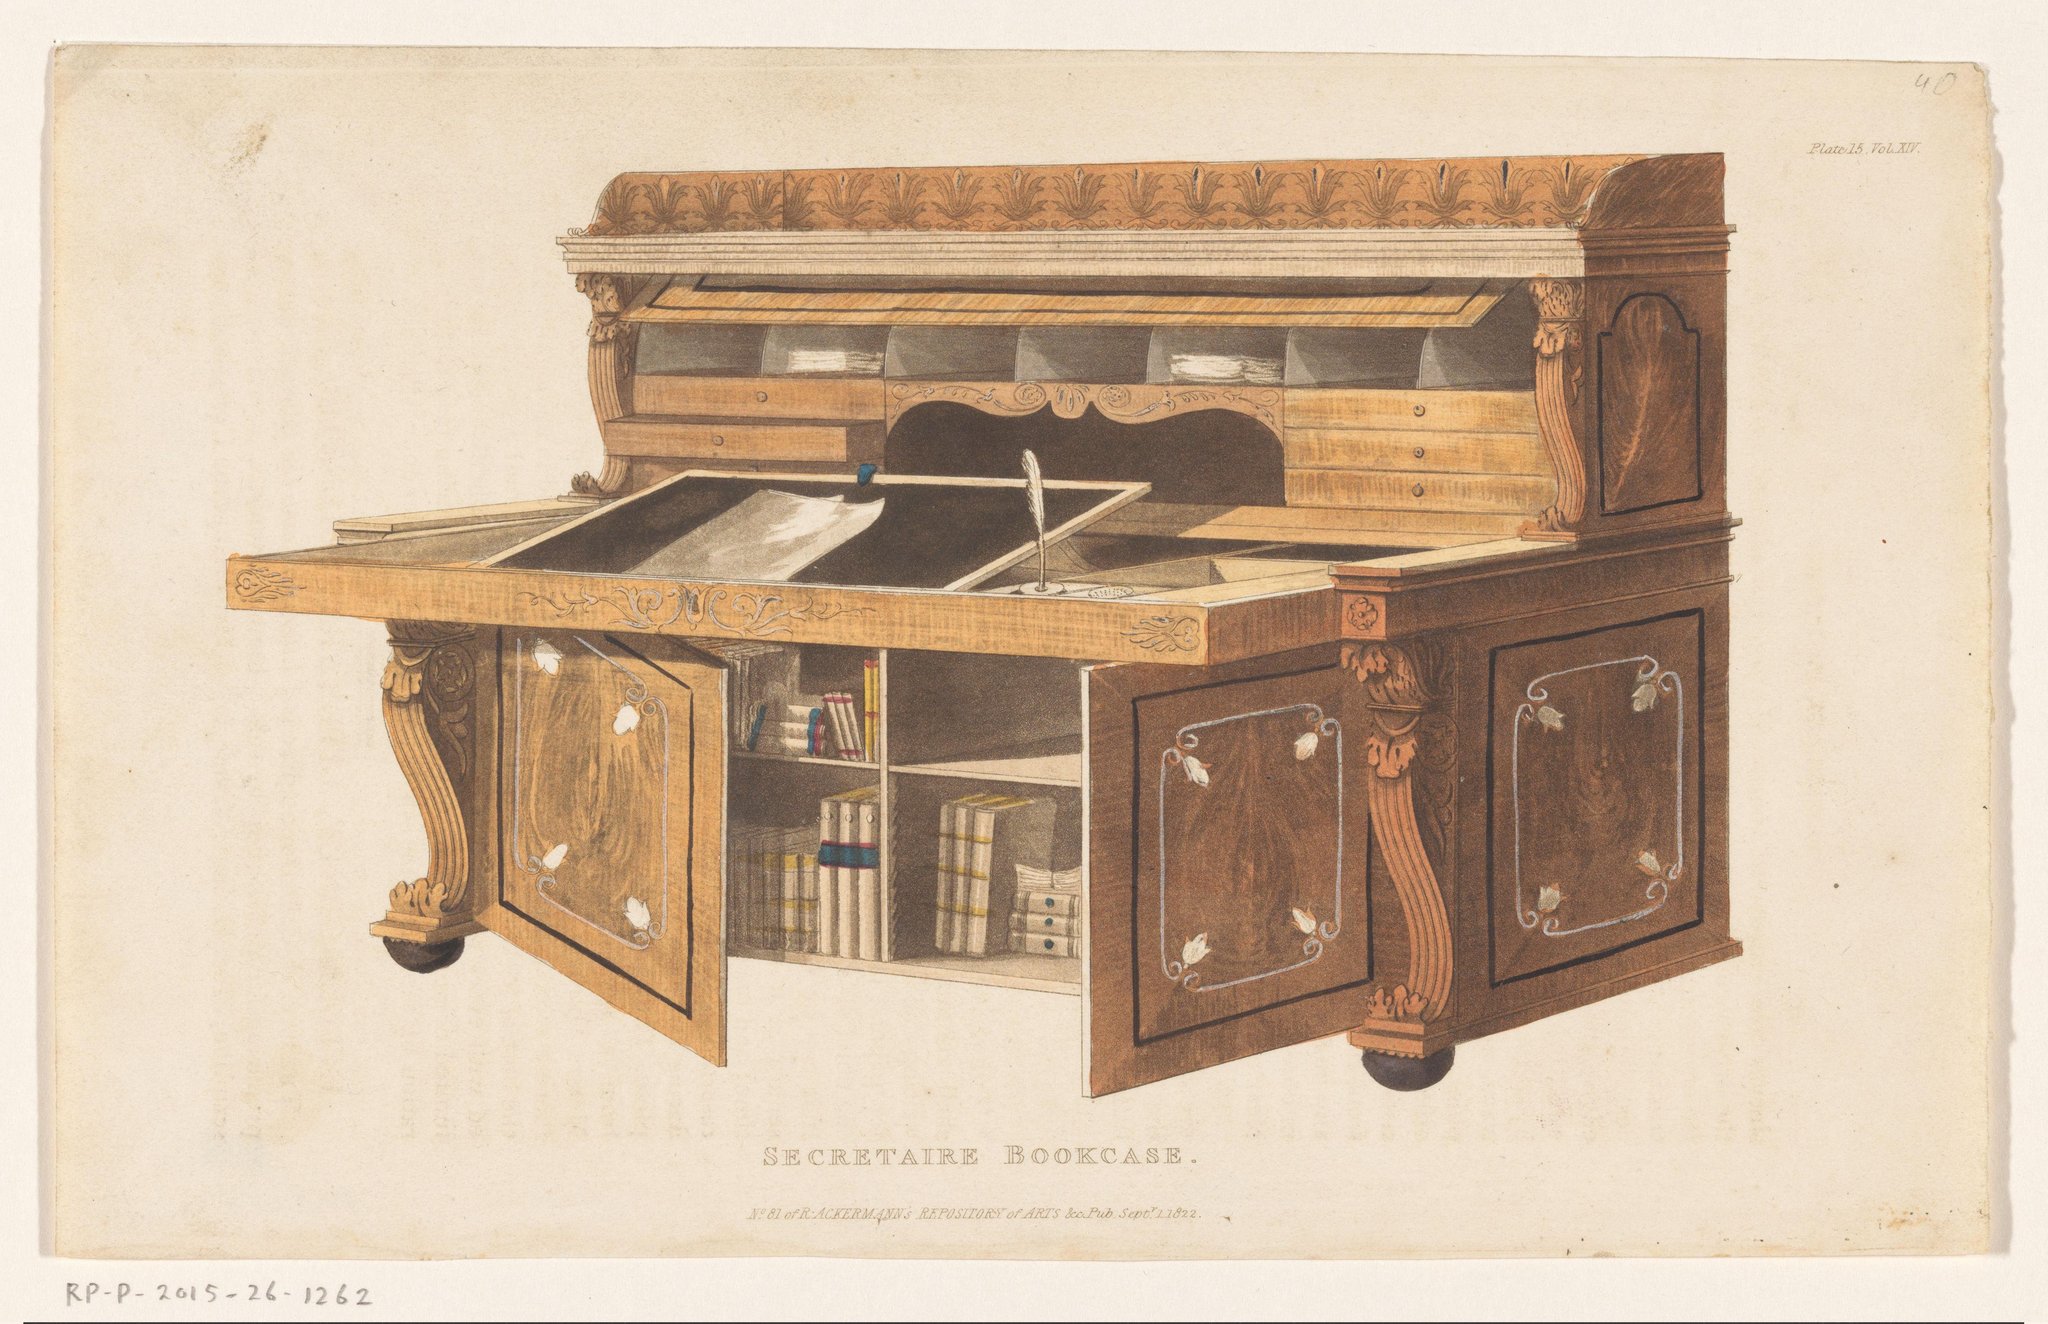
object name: print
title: Secretaire met ruimte voor boeken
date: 1809-1822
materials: paper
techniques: aquatint, hand coloring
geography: london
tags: bookshelves, furniture for storage, globe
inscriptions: collector's mark: Lugt 4780, collector's mark: Lugt 2228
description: Prent afkomstig uit: Ackermann's Repository of arts, literature, commerce, manufactures, fashions, and politics.